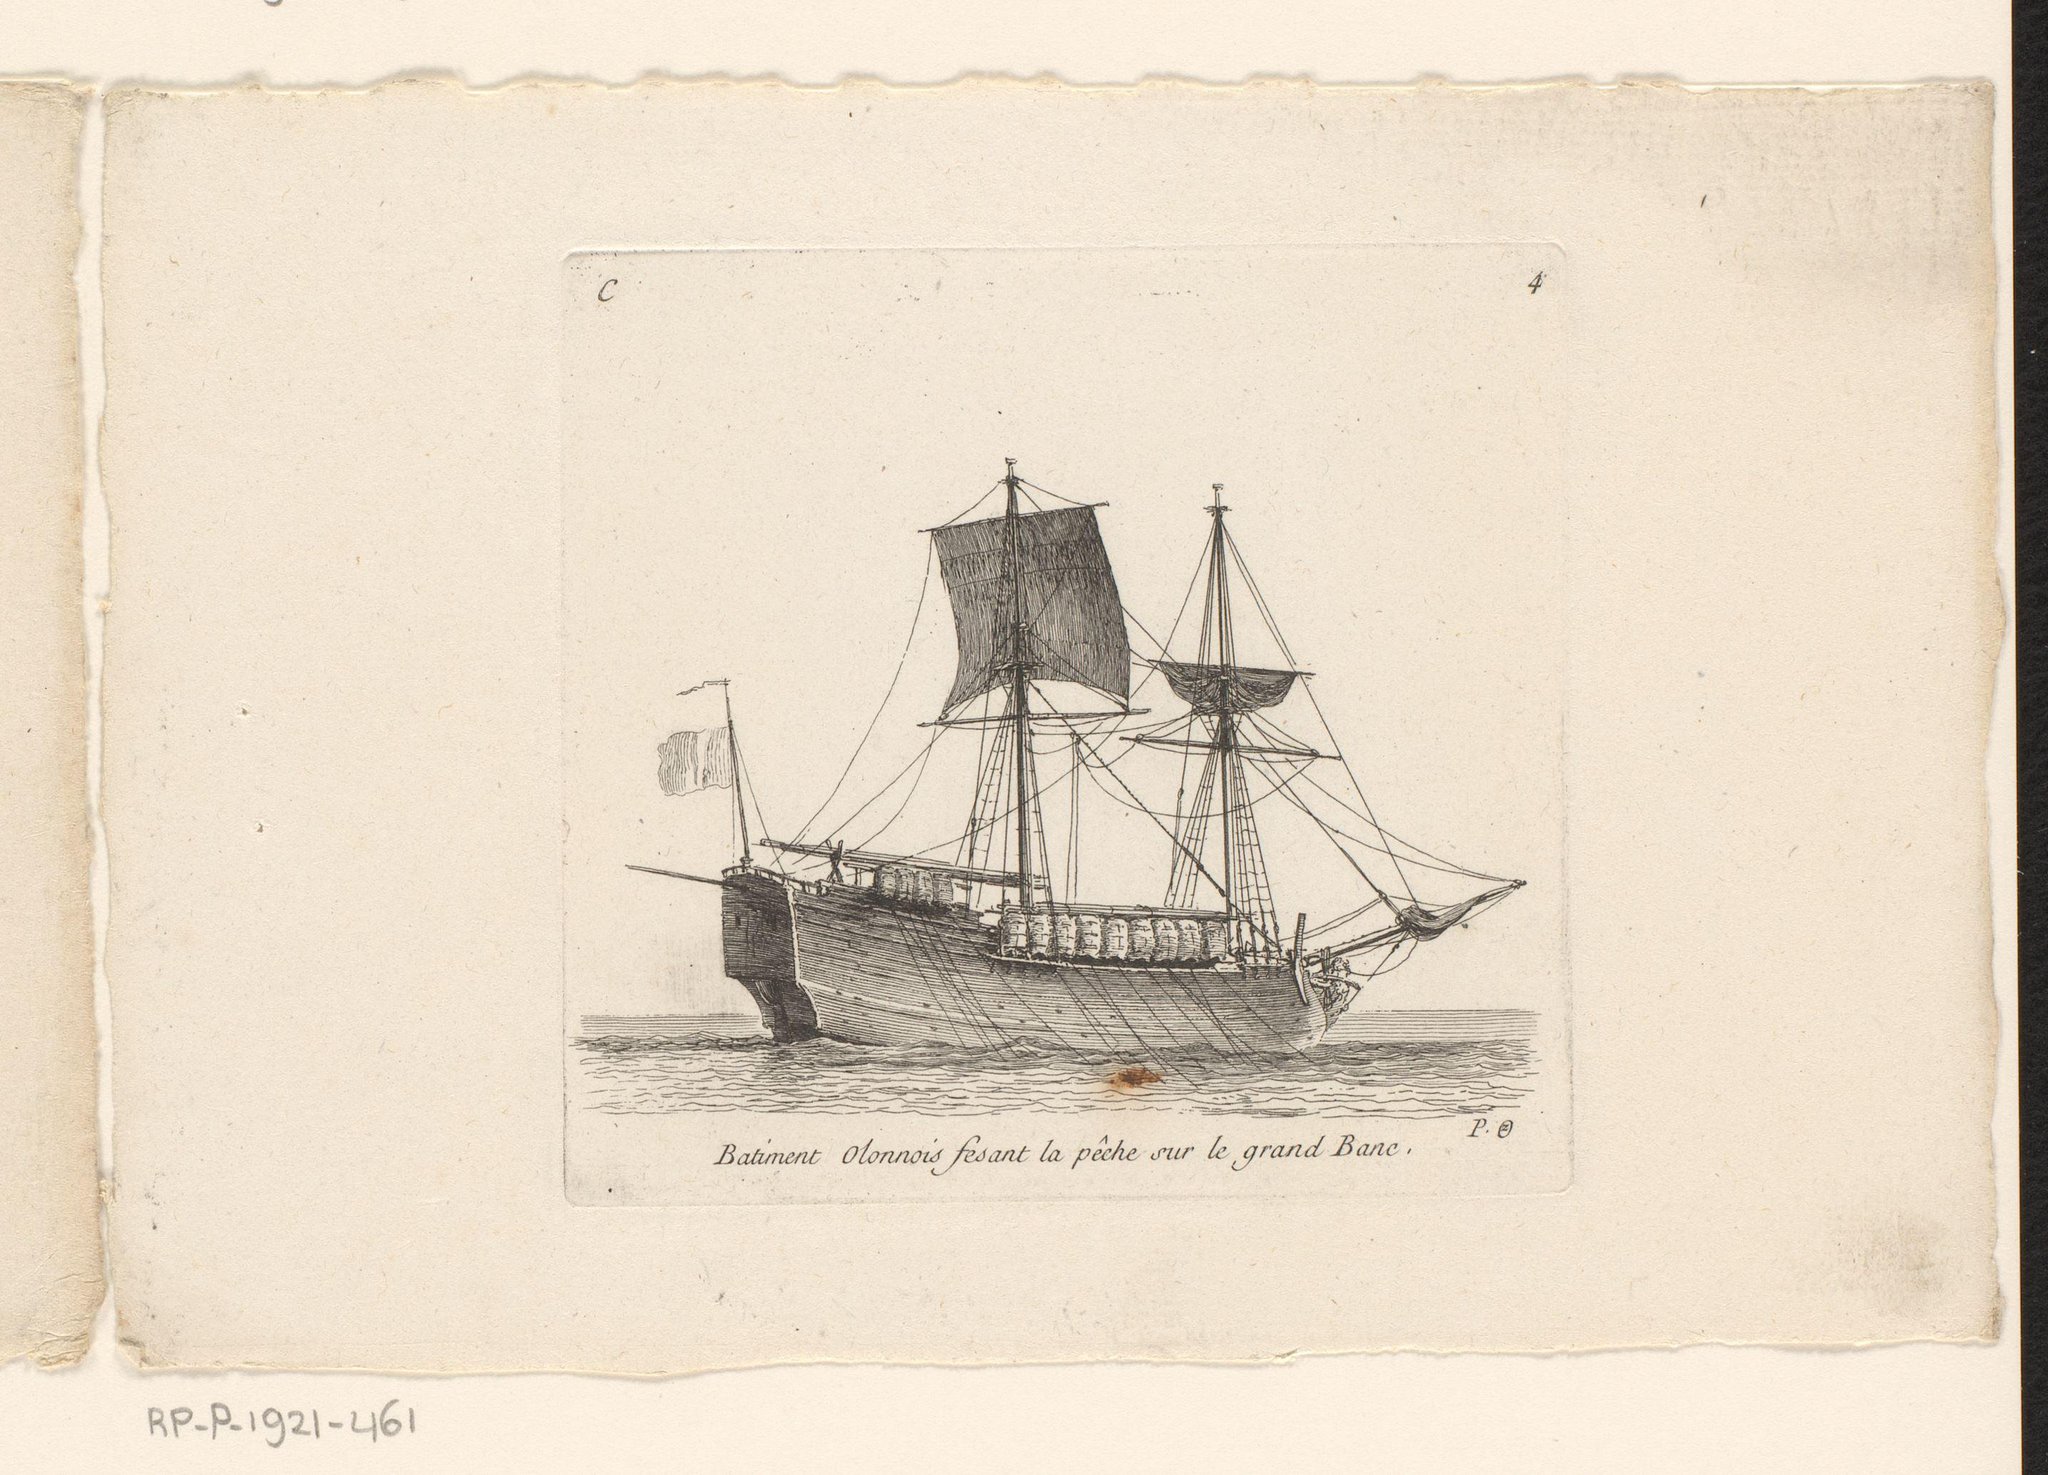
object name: print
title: Batiment Olonnois fesant la pêche sur le grand Banc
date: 1747-1813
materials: paper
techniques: etching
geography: paris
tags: commercial fishery, sailing-ship, sailing-boat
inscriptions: collector's mark: Lugt 2233